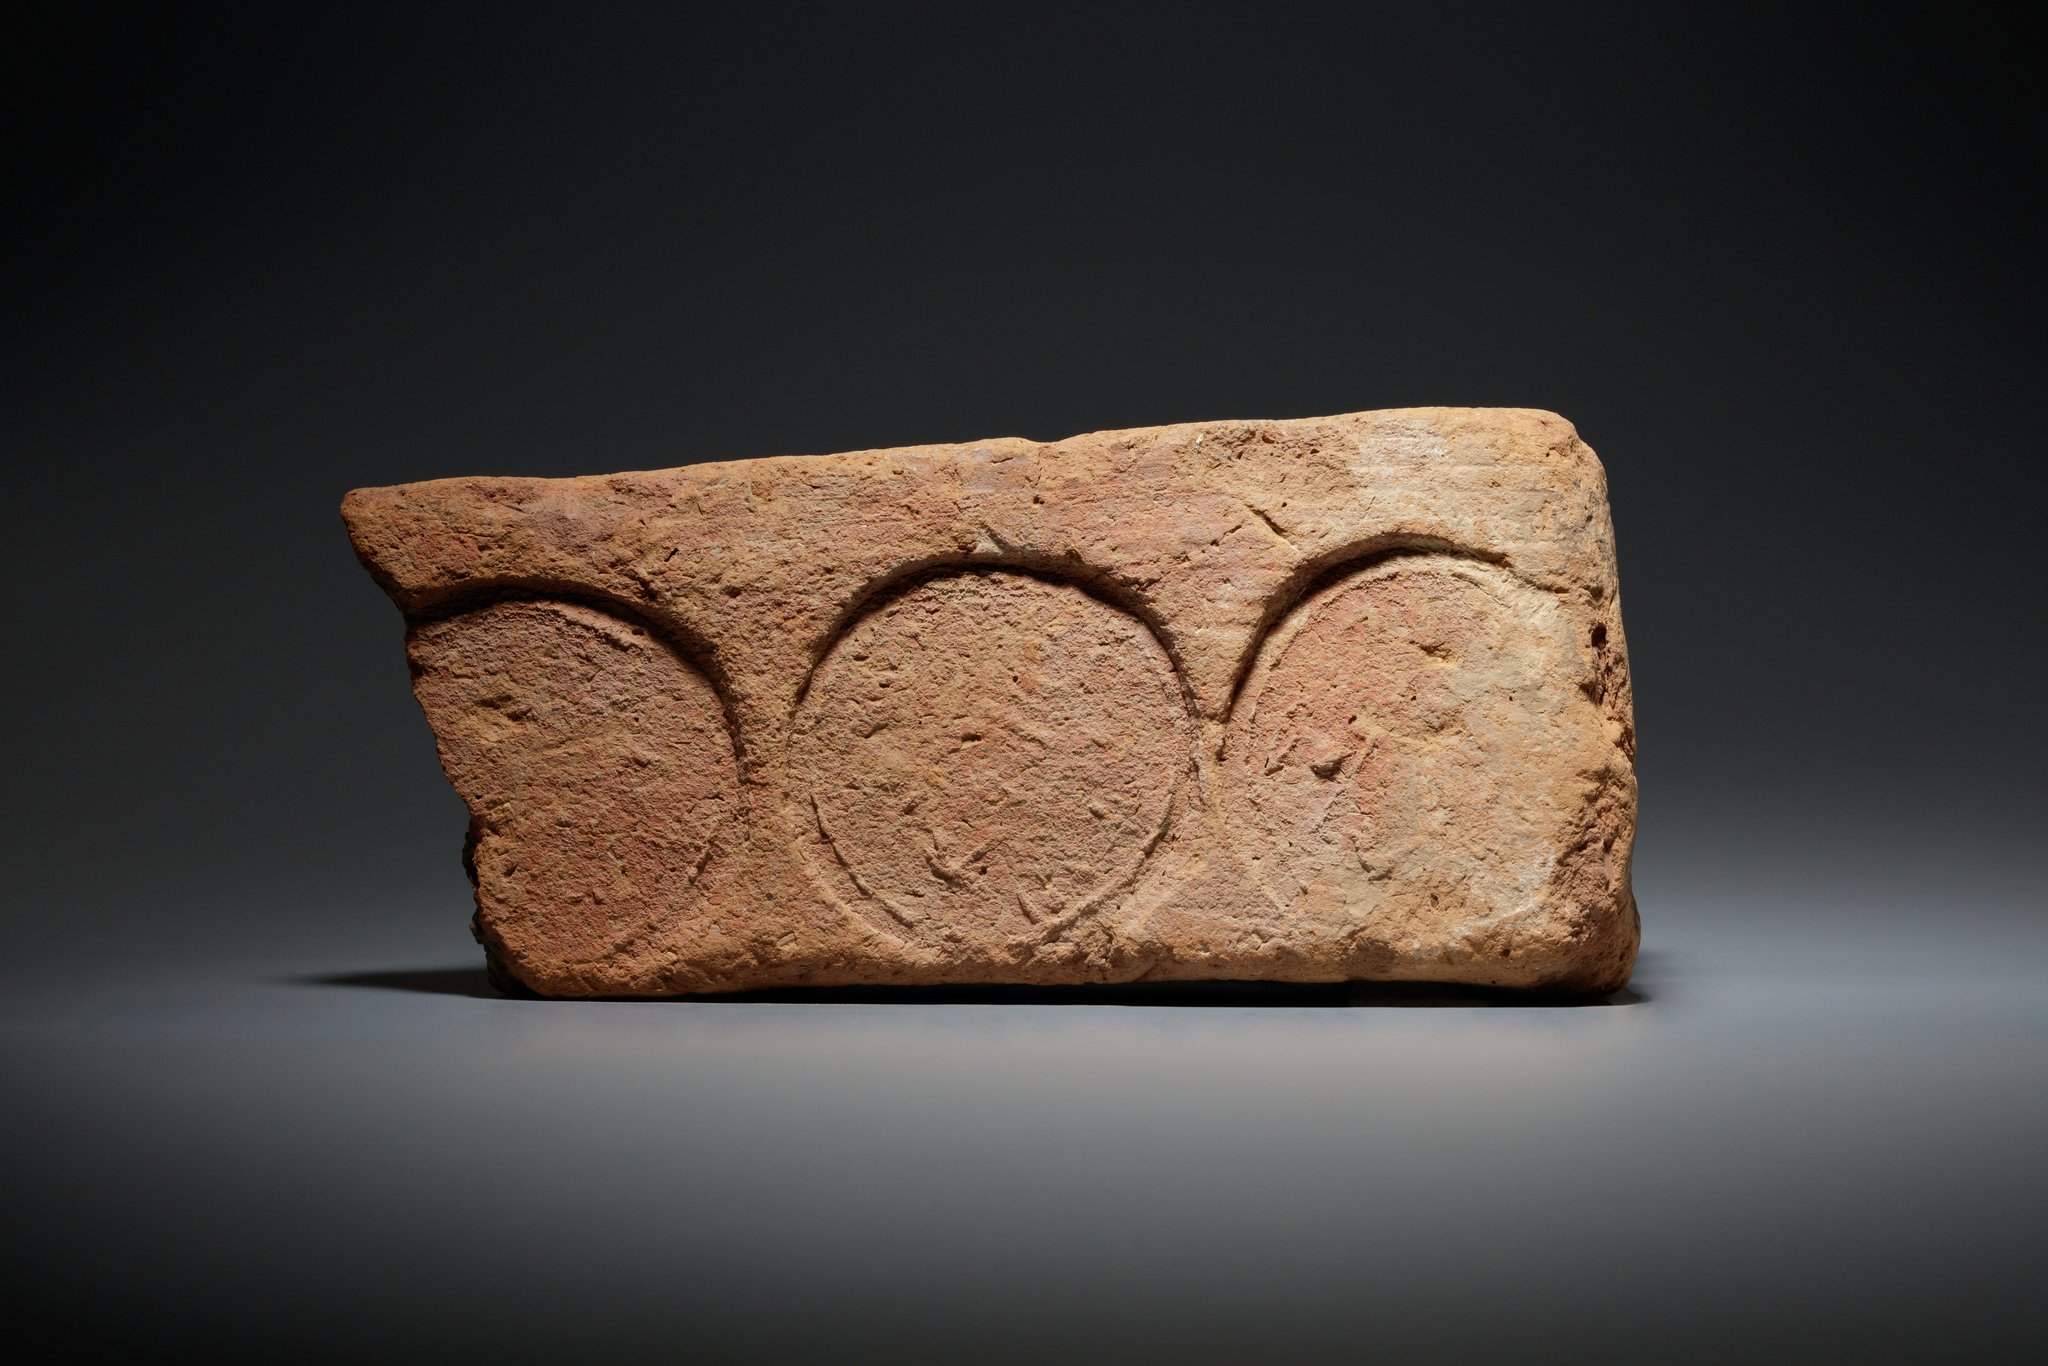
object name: cone, brick, davy 518, hapuseneb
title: Brick Stamped with a Circular Seal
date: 1550-1295 BCE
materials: pottery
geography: egypt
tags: hieroglyphs